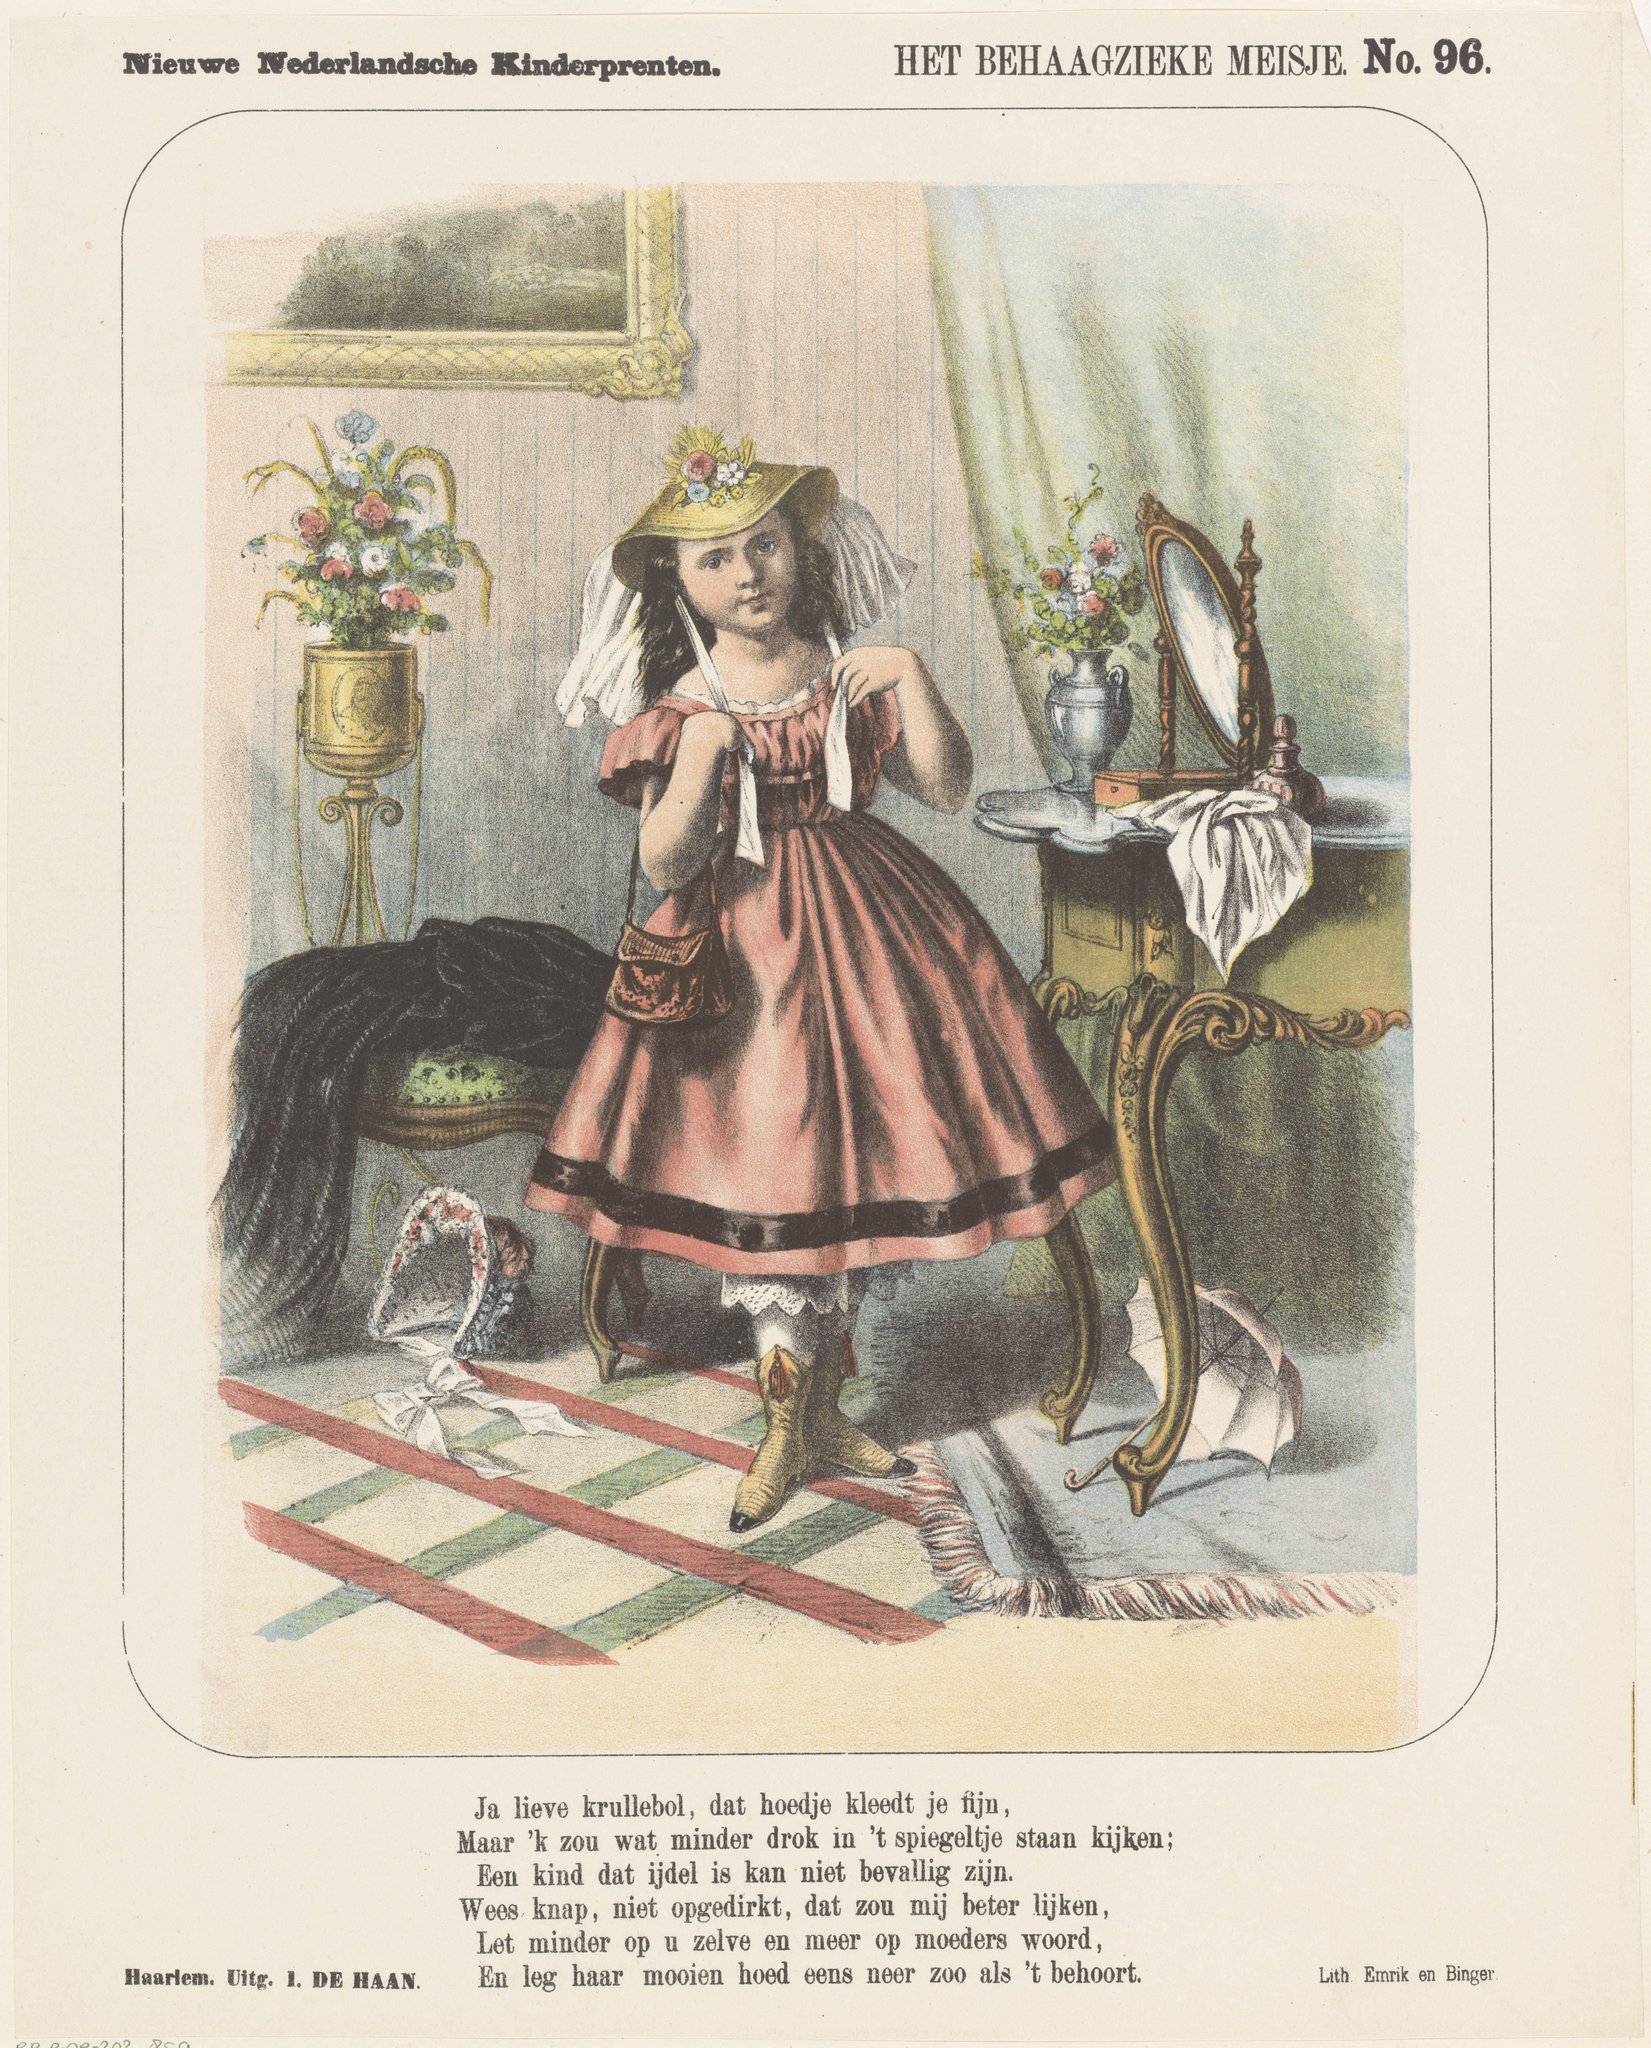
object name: print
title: Het behaagzieke meisje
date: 1875-1903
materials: paper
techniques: lithograph, letterpress printing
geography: haarlem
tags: idleness; 'otio' (ripa) (+ 'exemplum', representation of exemplary (historical) event), mirror, child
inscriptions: collector's mark: Lugt 2760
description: Blad met een grote voorstelling van een ijdel meisje. Ze past de hoed van haar moeder voor de spiegel. Onder de voorstelling een zesregelig vers. Genummerd rechtsboven: No. 96.